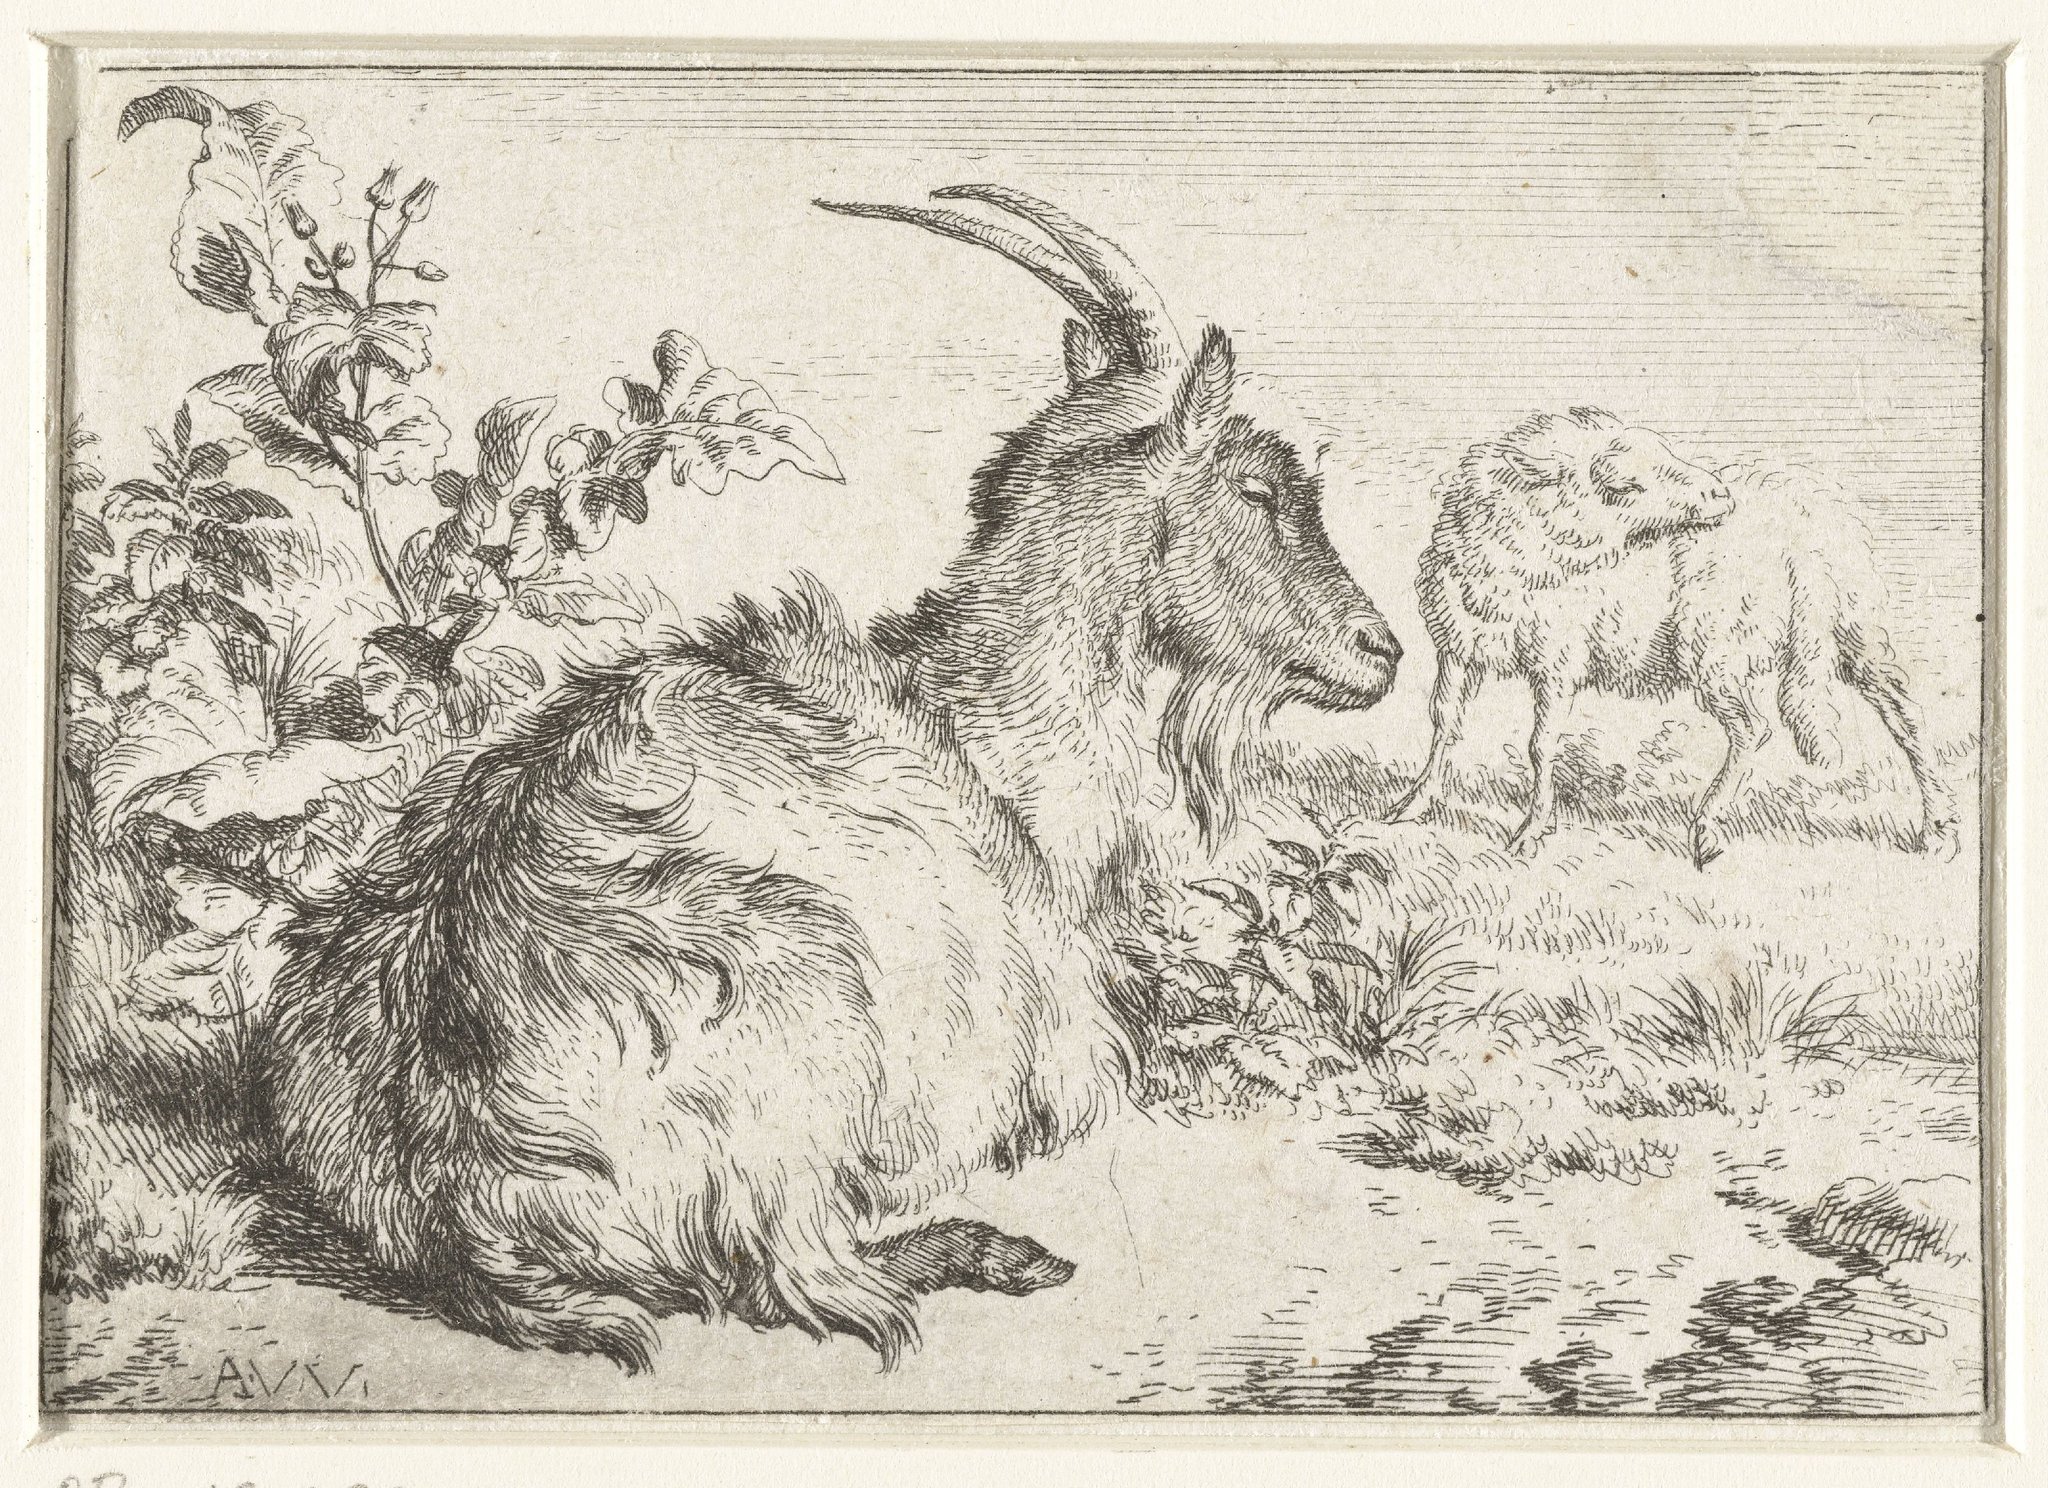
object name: print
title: Schapen en geiten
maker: adriaen van de velde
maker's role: draughtsman, painter, print maker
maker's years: 1636-1672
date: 1670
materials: paper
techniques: etching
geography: amsterdam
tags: she-goat, nanny-goat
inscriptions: collector's mark: Lugt 240